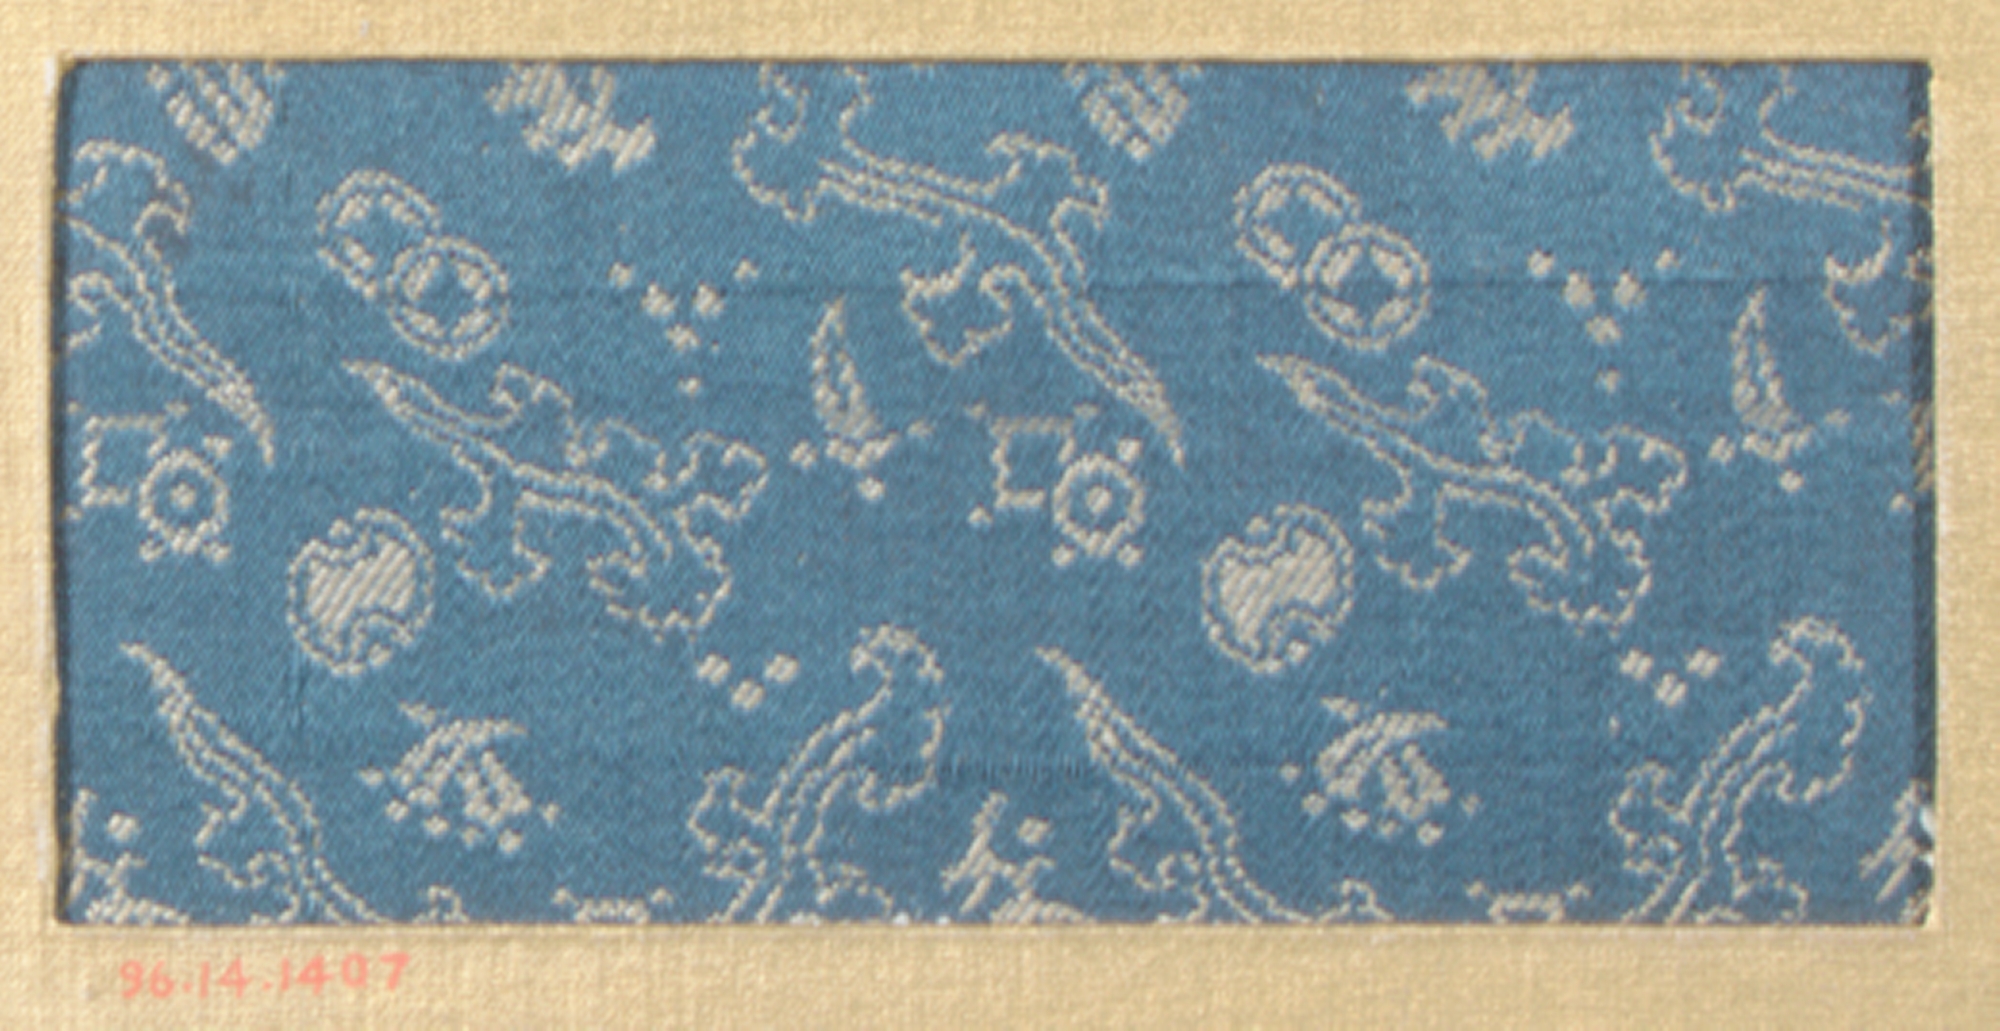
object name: piece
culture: japanese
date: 1701-1900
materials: silk